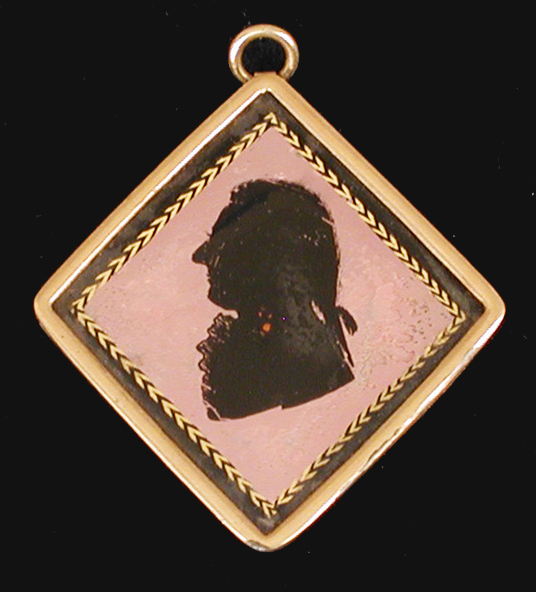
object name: locket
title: Locket (one of a pair)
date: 1801-1900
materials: glass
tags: profiles